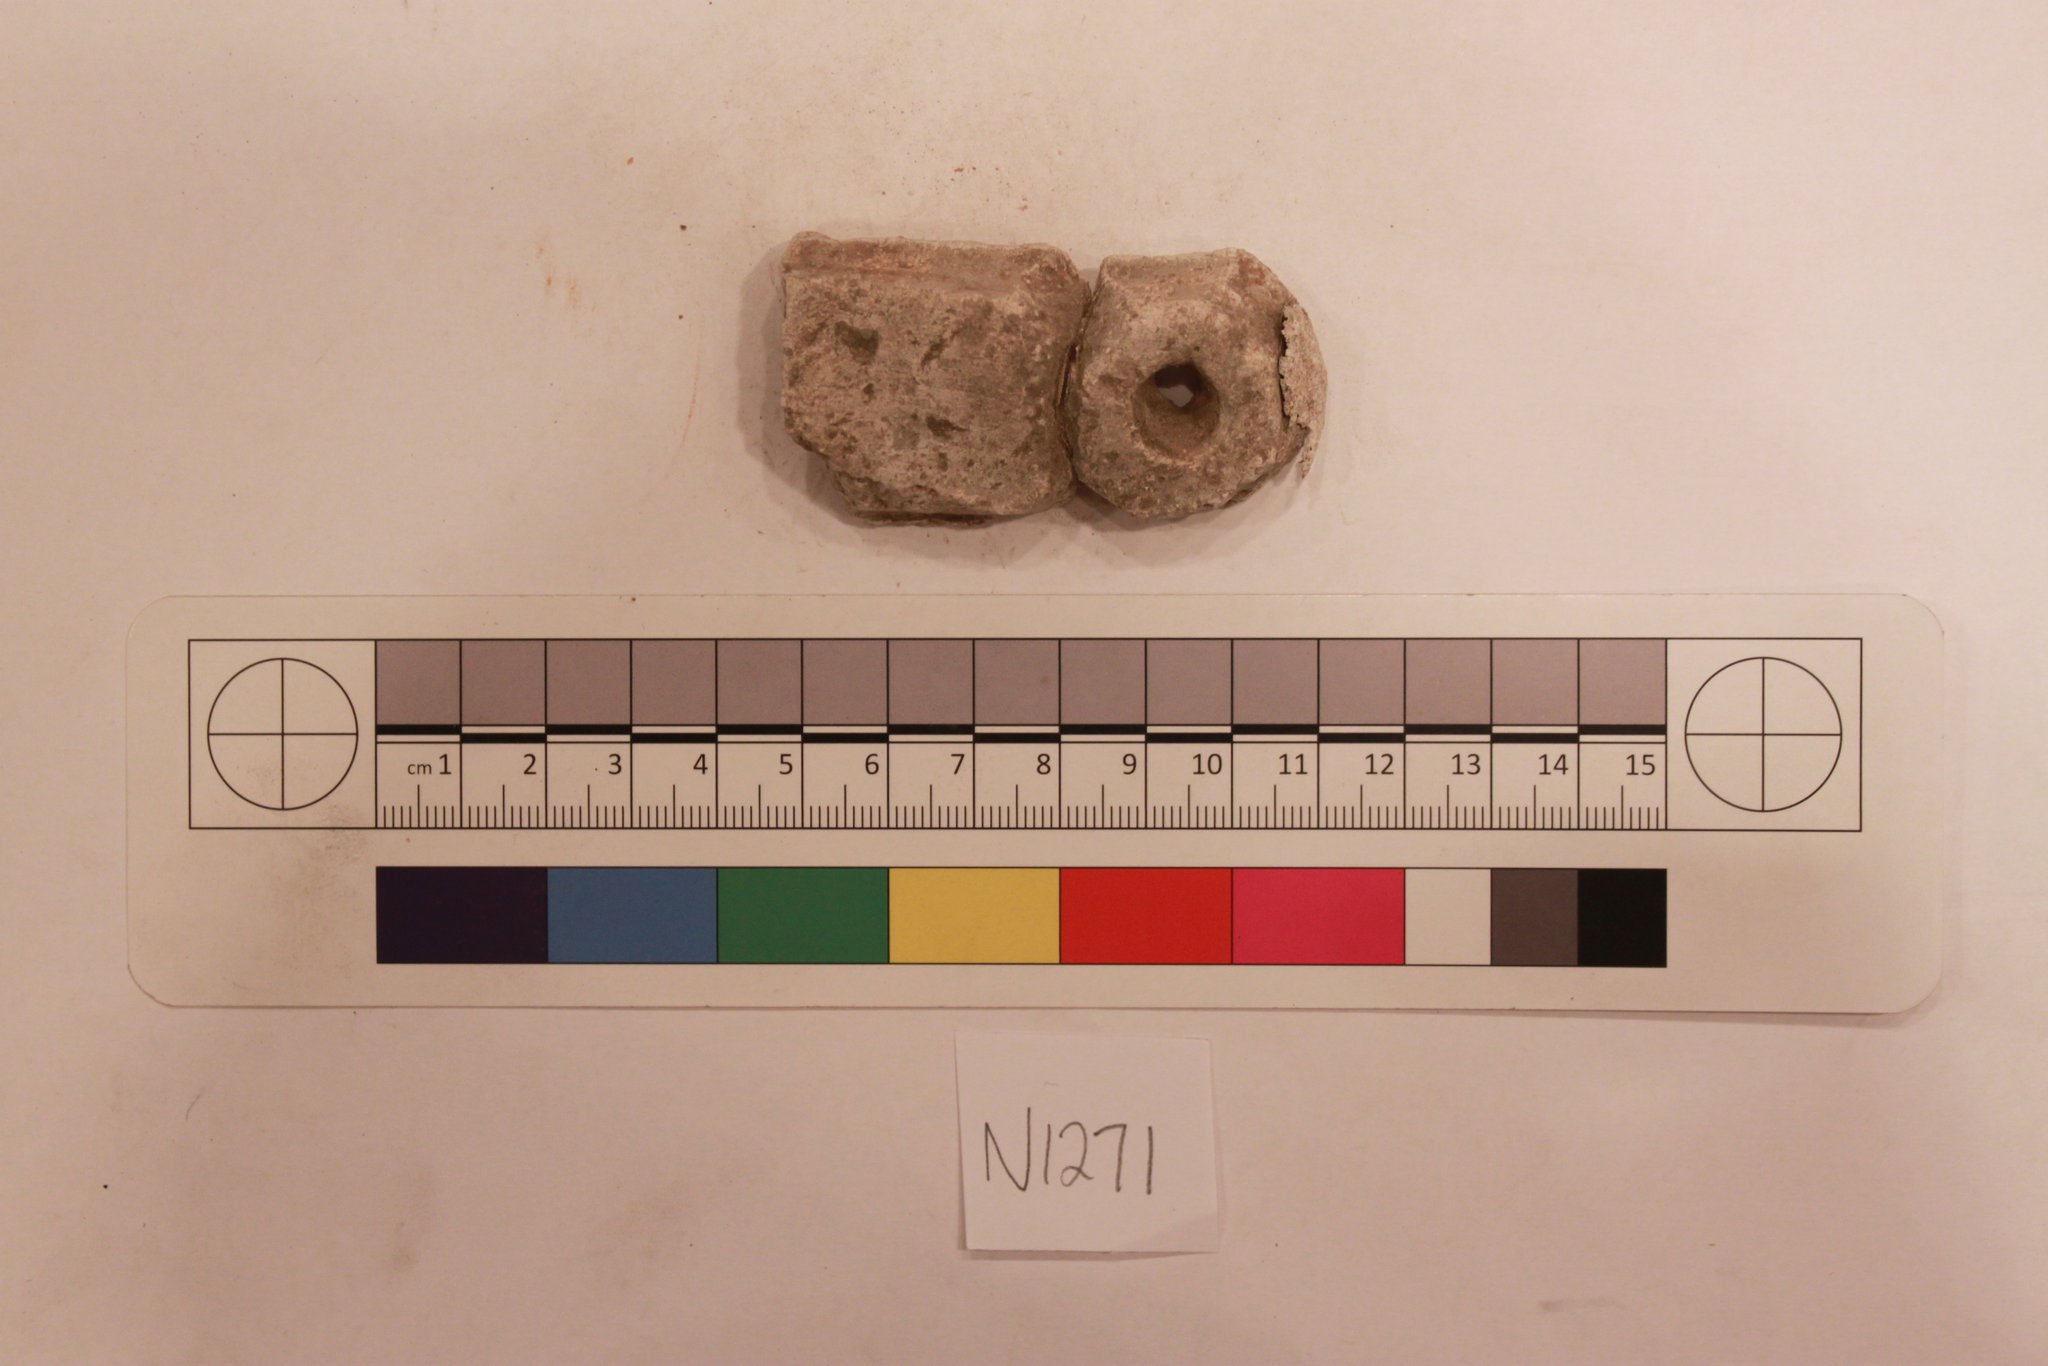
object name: fragment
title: Stucco Fragment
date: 701-1200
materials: plaster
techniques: carving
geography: iran